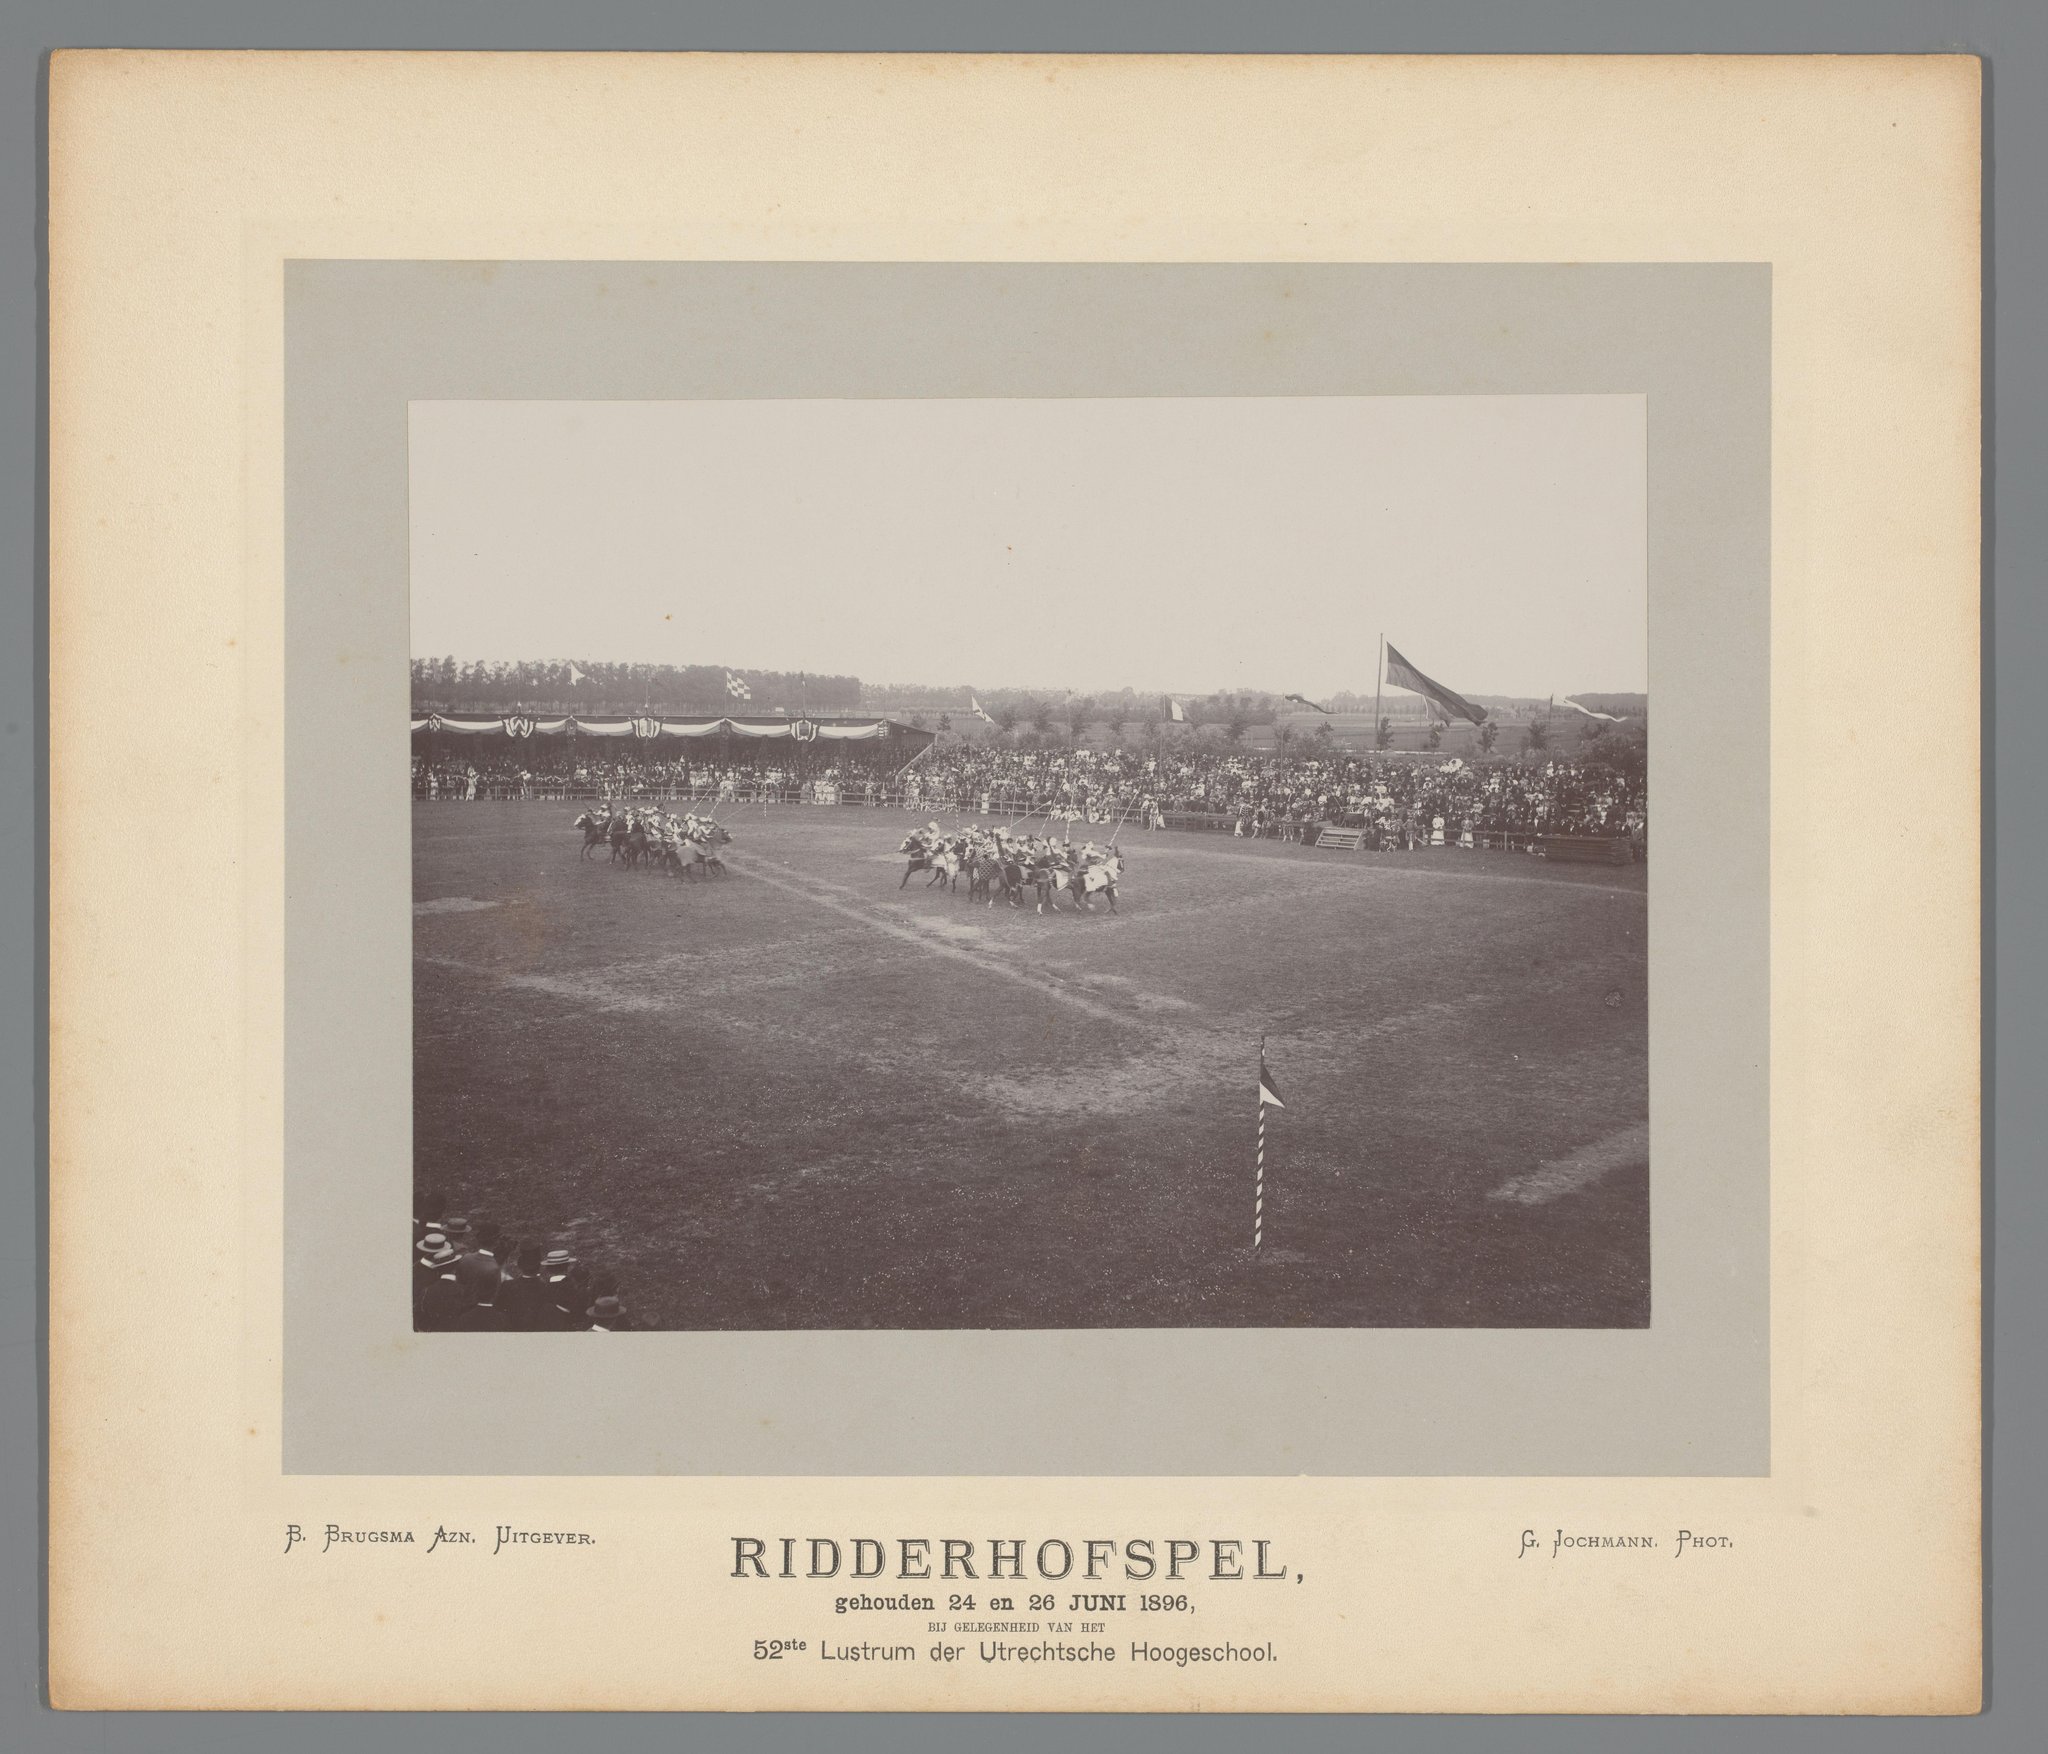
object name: photograph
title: Ridderhofspel, gehouden 24 en 26 juni 1896, bij gelegenheid van het 52ste Lustrum der Utrechtsche Hoogeschool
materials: cardboard, paper, photographic support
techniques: collodion silver print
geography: utrecht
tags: (medieval) fighting contest, public festivities, fighting, utrecht